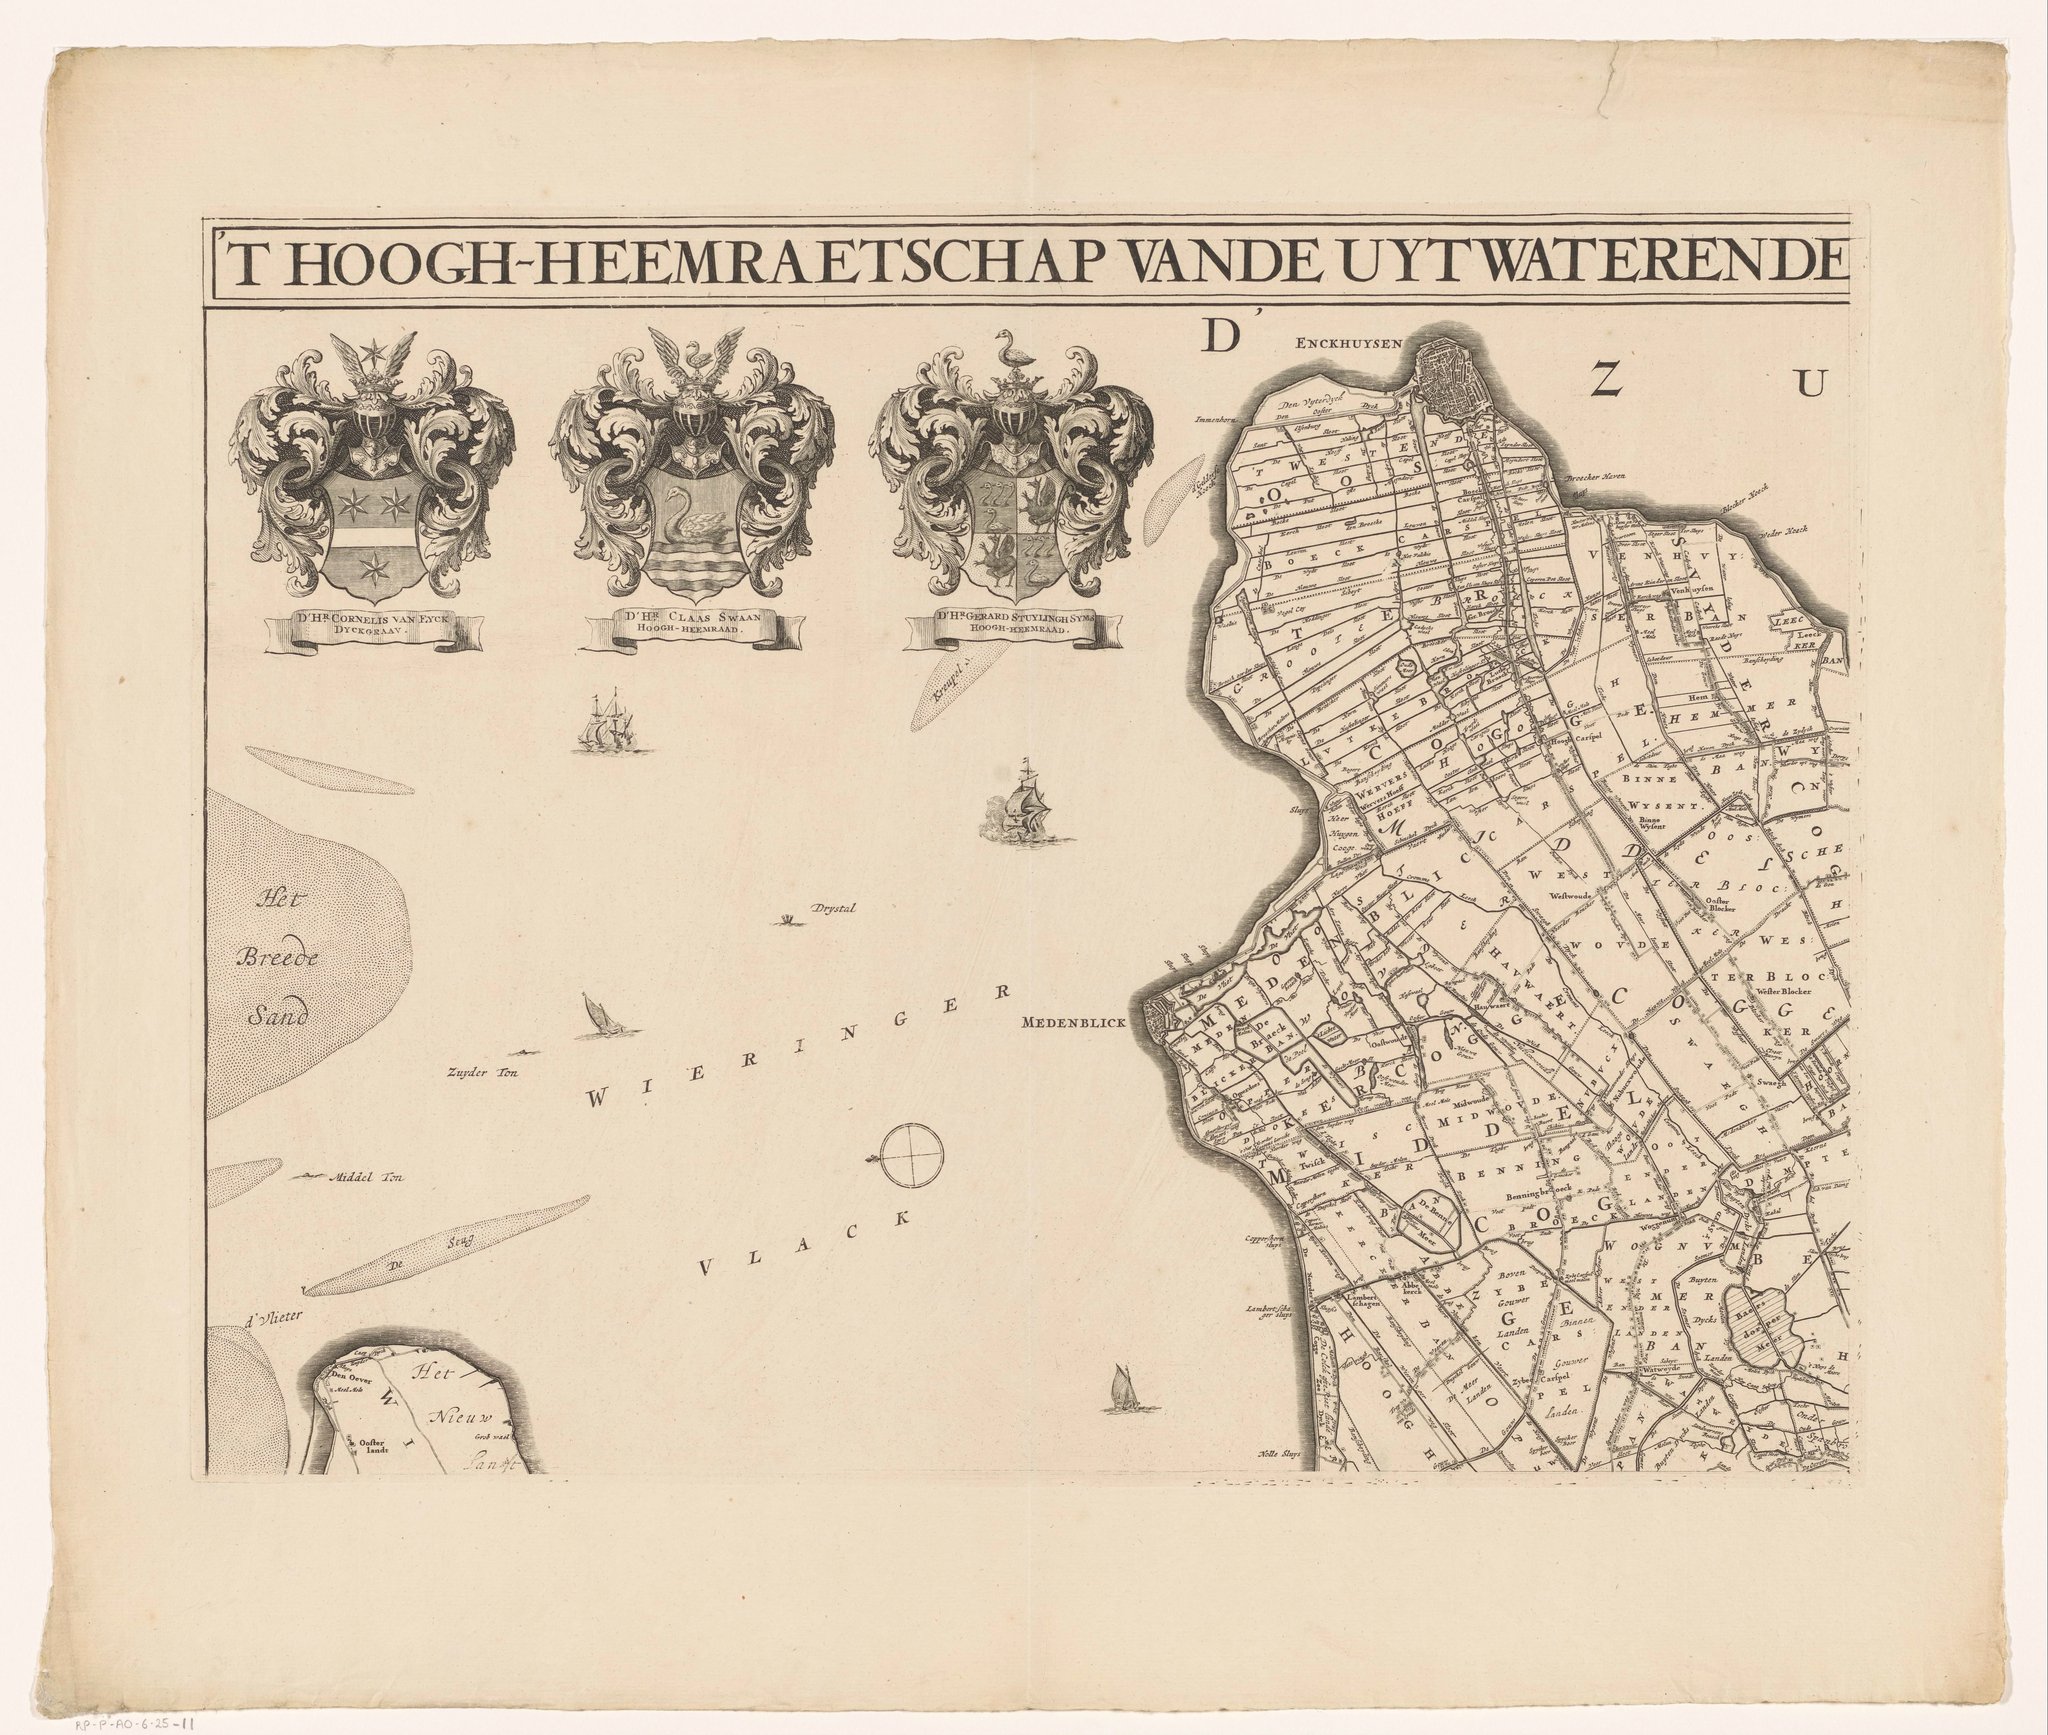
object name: print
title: Kaart van Kennemerland en West-Friesland (deel linksboven)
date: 1745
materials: paper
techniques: engraving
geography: amsterdam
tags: coat of arms (as symbol of the state, etc.), maps of separate countries or regions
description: Deel (linksboven) van een kaart van Kennemerland en West-Friesland.